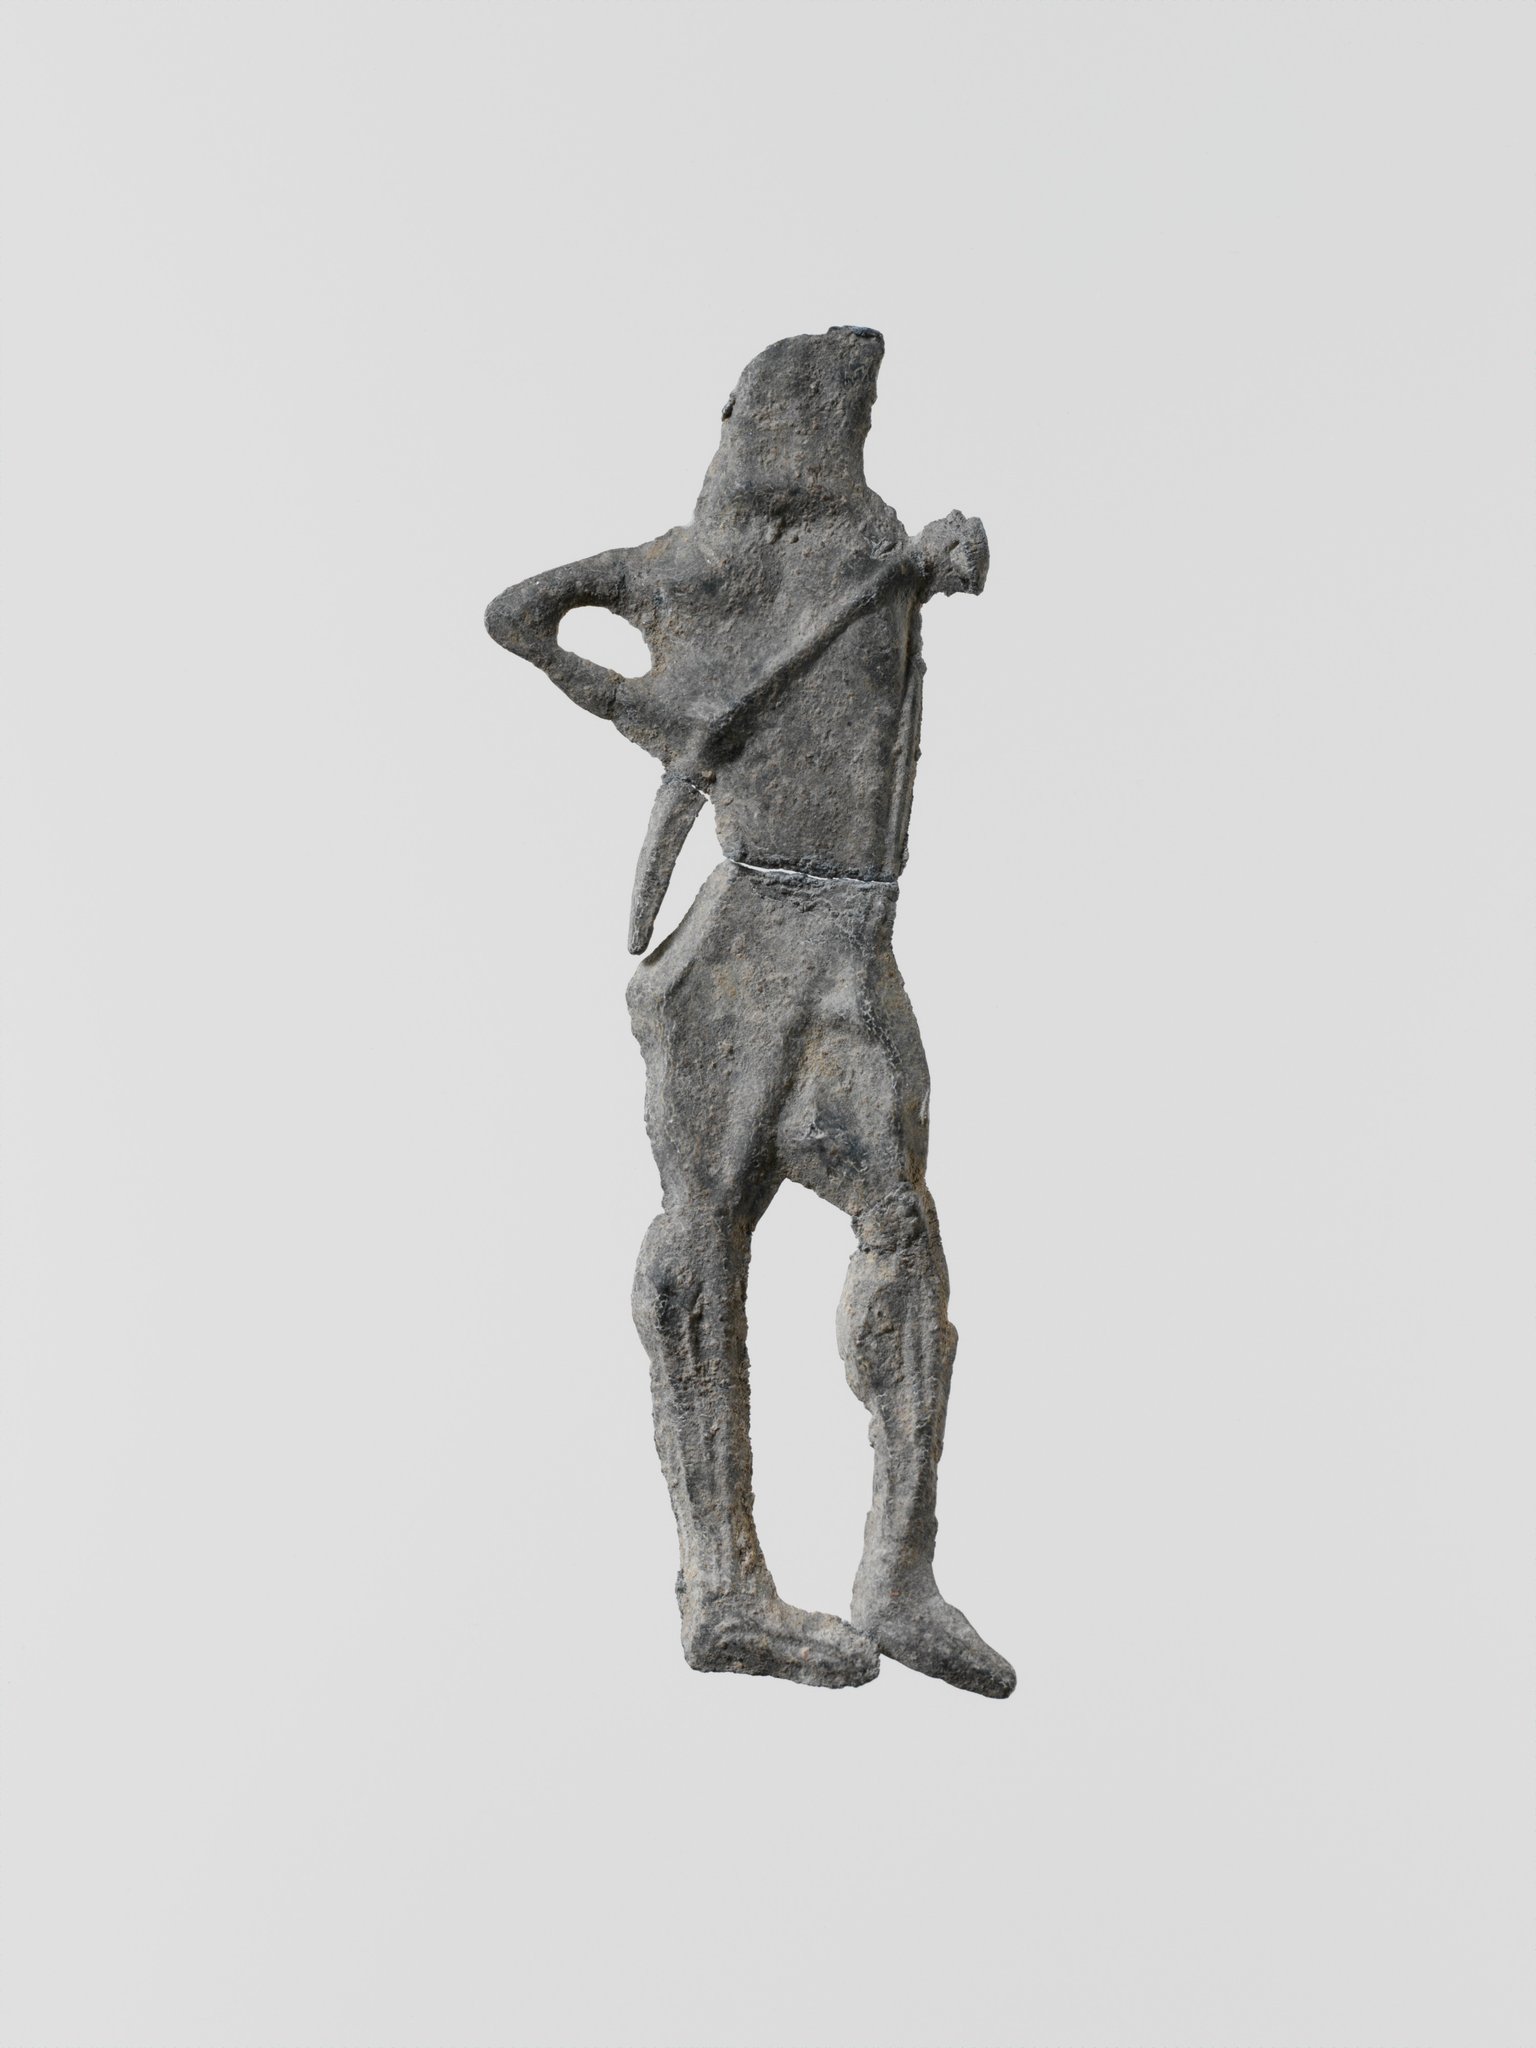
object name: statuette of an archer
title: Lead figure of an archer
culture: greek, laconian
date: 600-401 BCE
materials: lead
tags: men